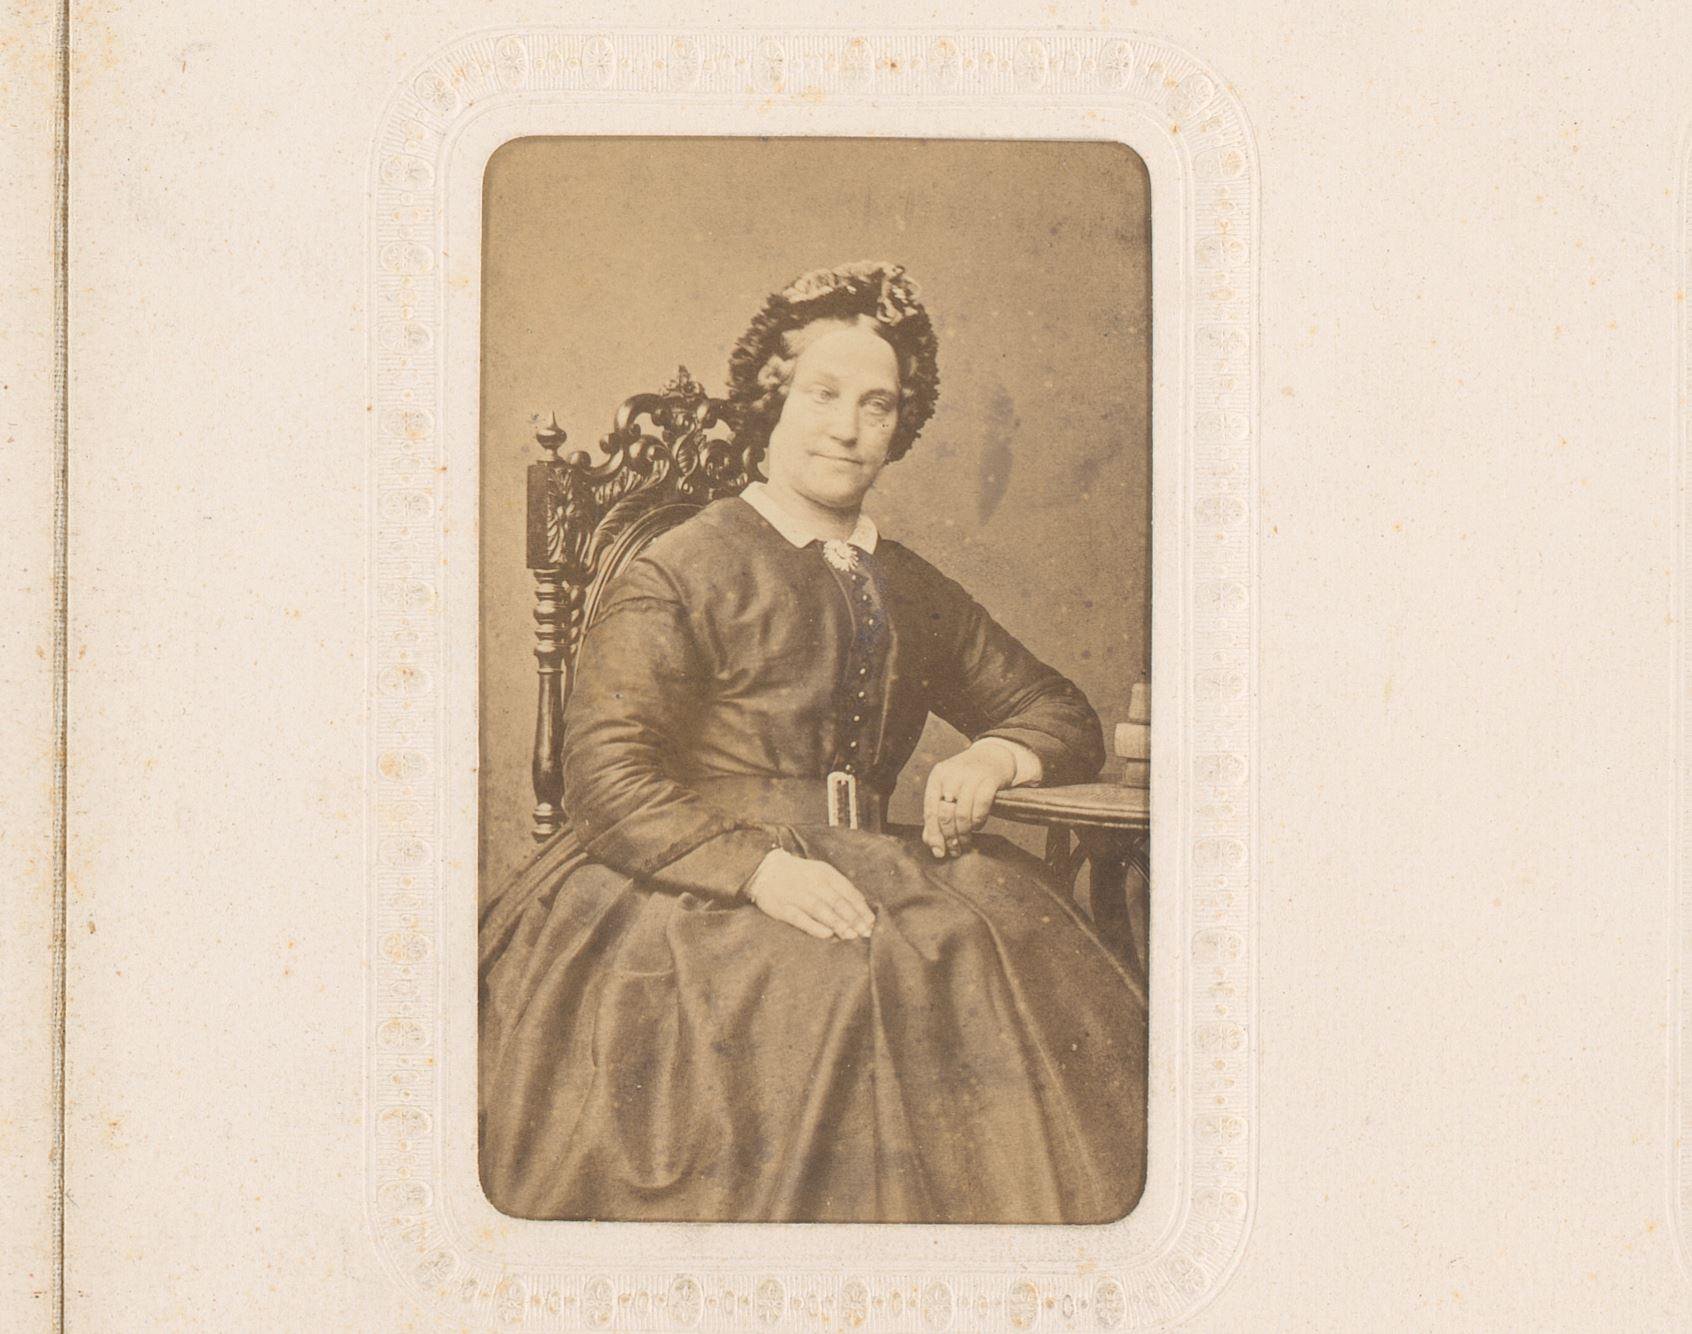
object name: album leaf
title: Portret van Machtelt Bletz, zittend op een stoel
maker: Anonymous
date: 1860-1900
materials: cardboard, photographic support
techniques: albumen print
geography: netherlands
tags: sitting figure - aa - female human figure, historical persons - bb - woman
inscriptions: name: ‘Machtelt Bletz’